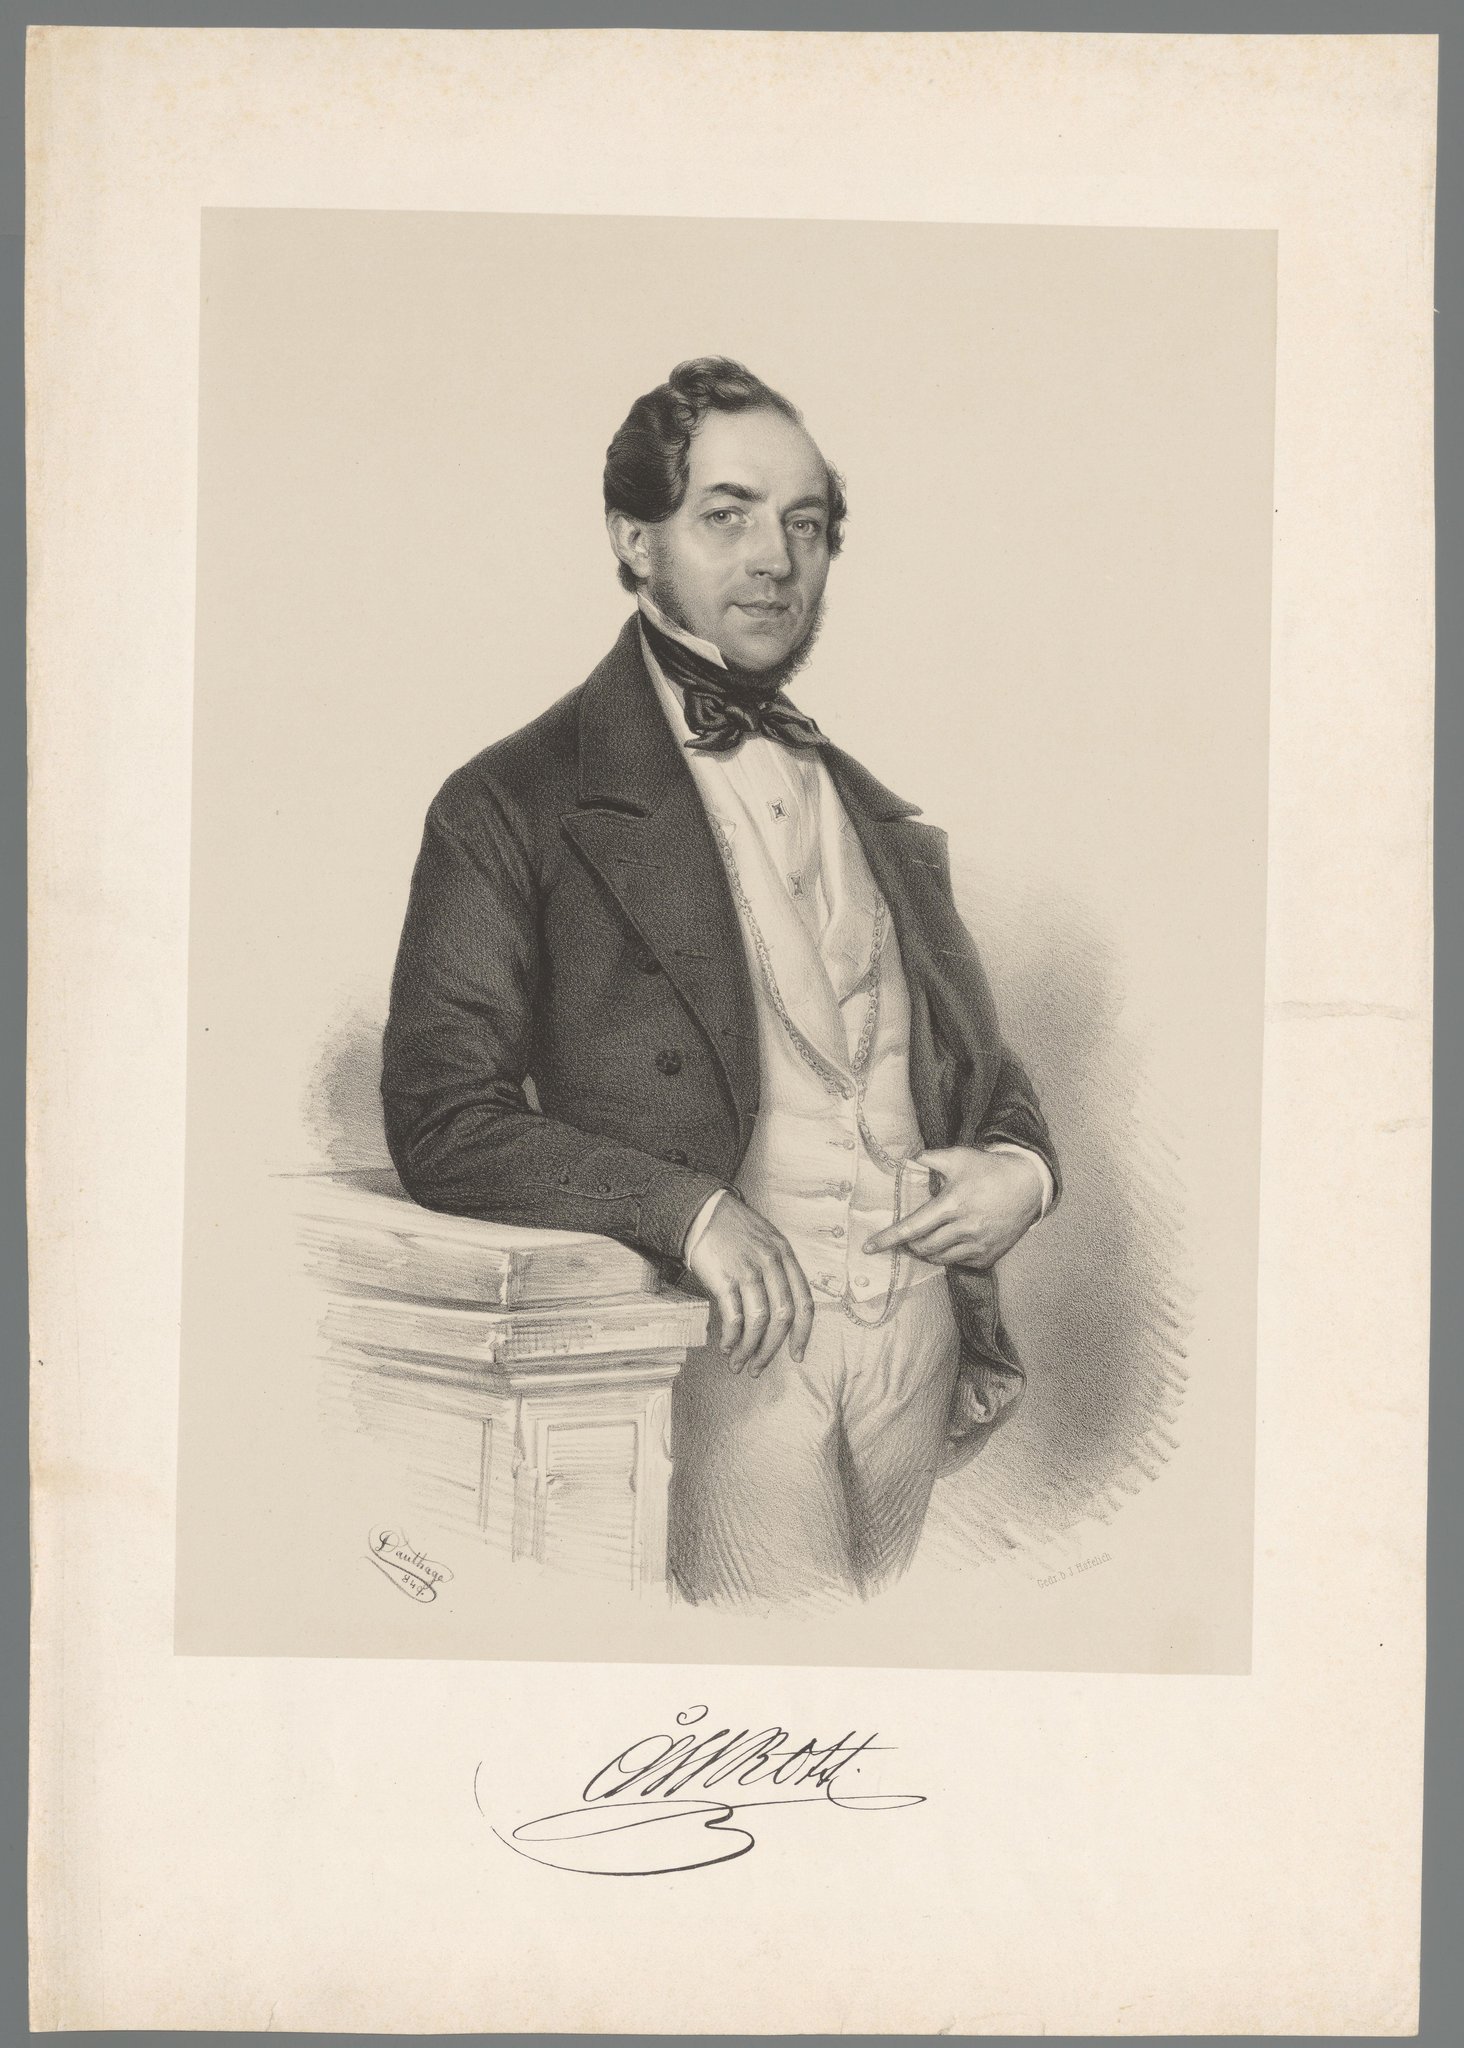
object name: print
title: Portret van Rott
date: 1849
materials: paper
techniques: lithograph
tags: adult man, historical persons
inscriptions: collector's mark: Lugt 2228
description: Portret van een verder onbekende man, met handtekening in facsimile waarin de naam Rott te lezen is.